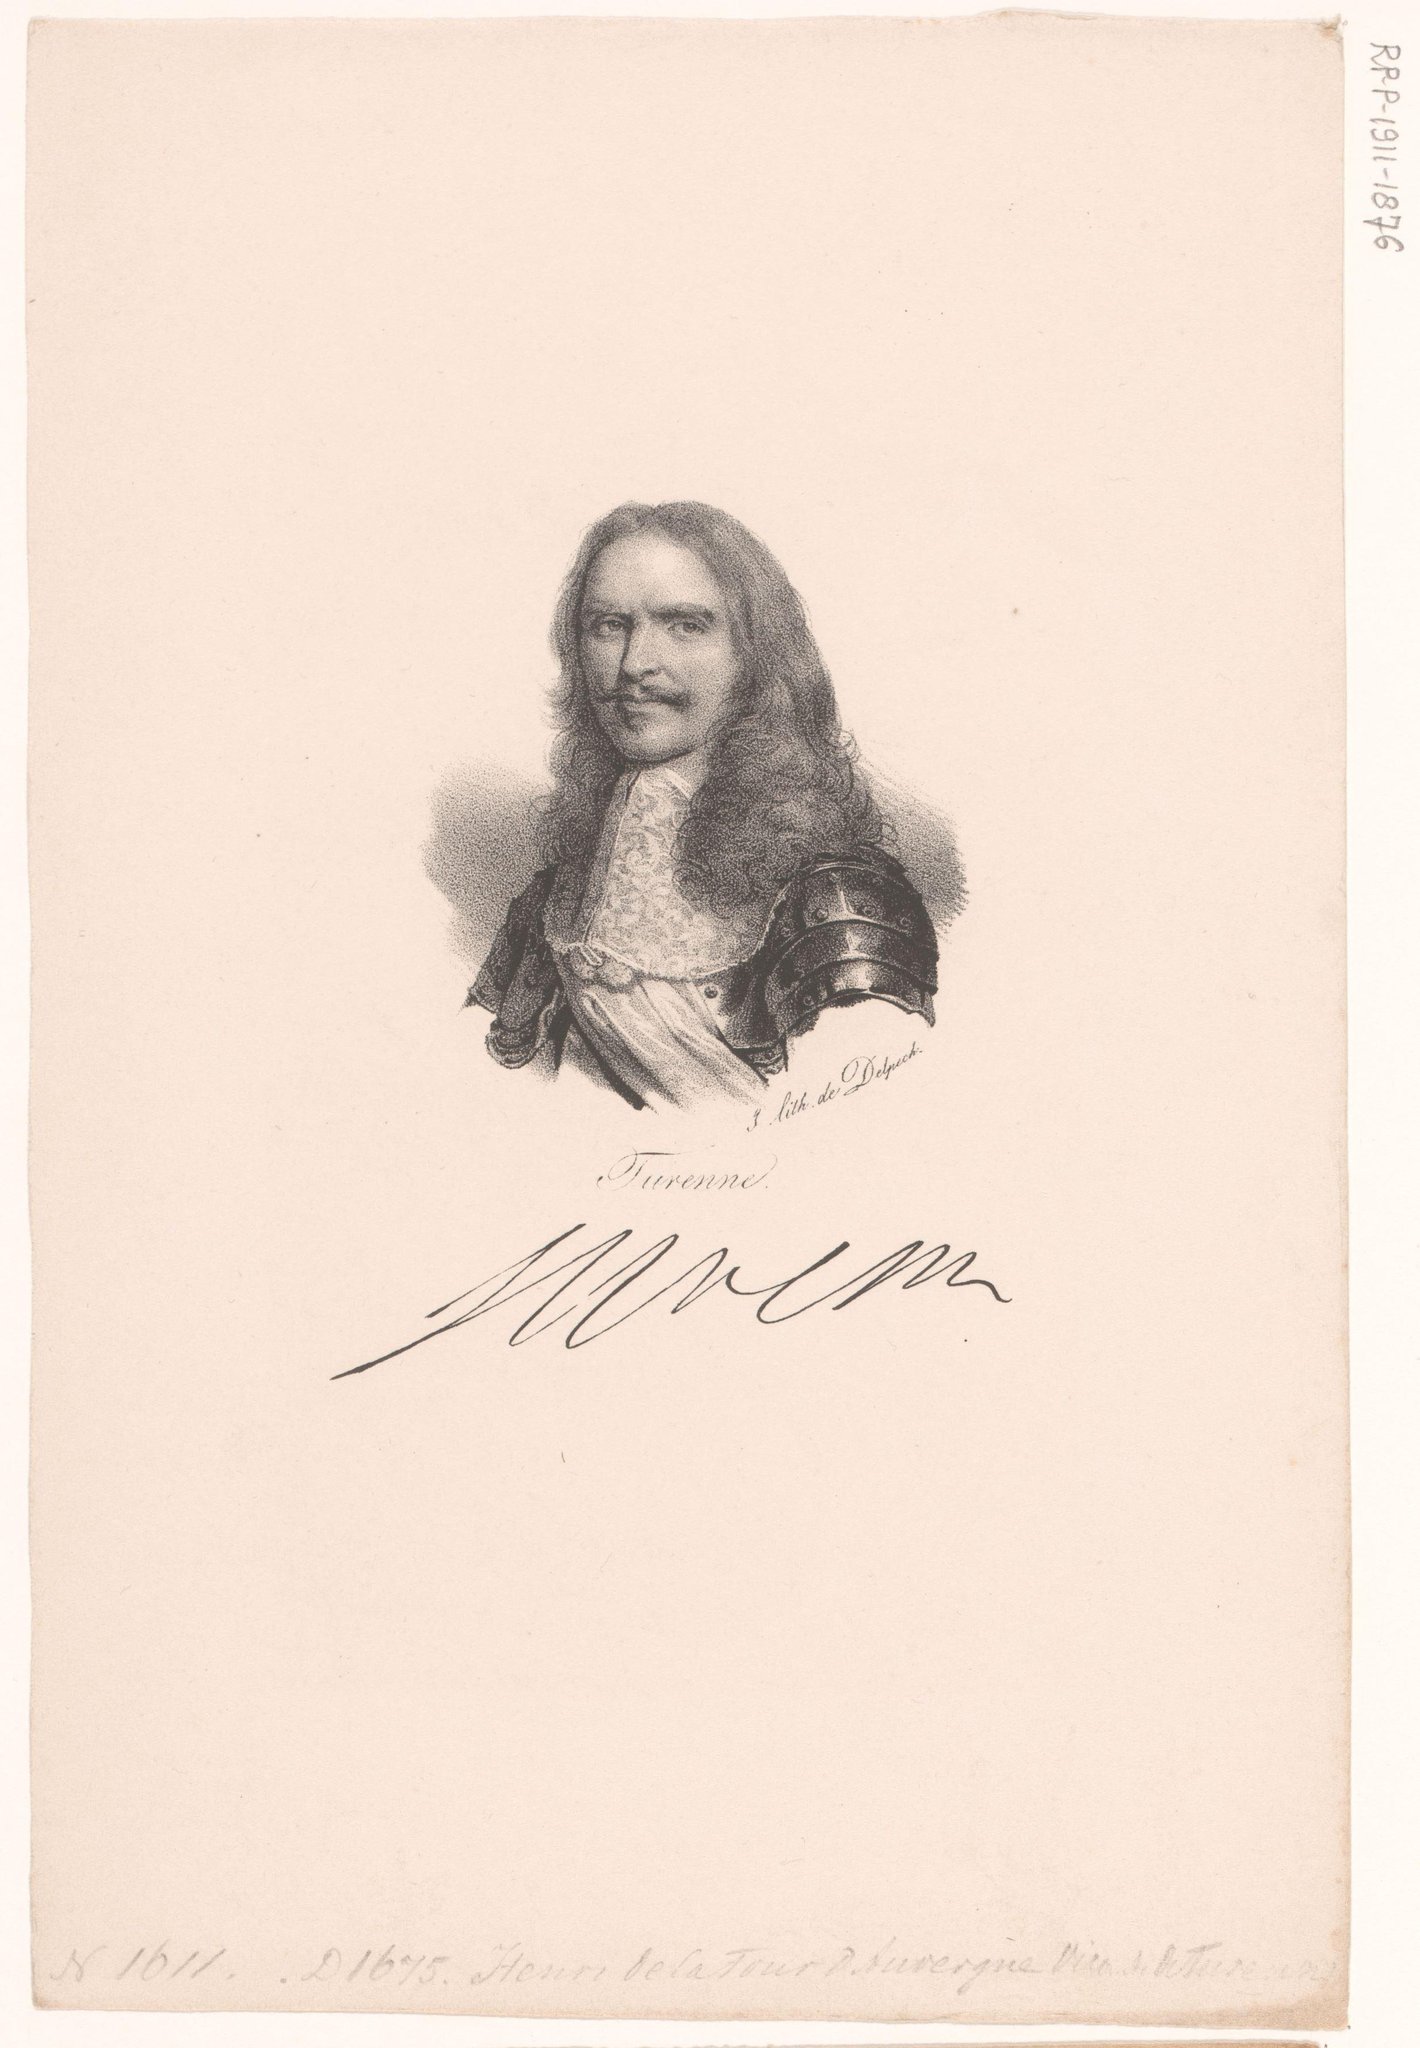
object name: print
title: Portret van Henri de La Tour d'Auvergne, genaamd Turenne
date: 1818-1842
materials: paper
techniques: lithograph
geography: paris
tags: historical persons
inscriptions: collector's mark: Lugt 2228a